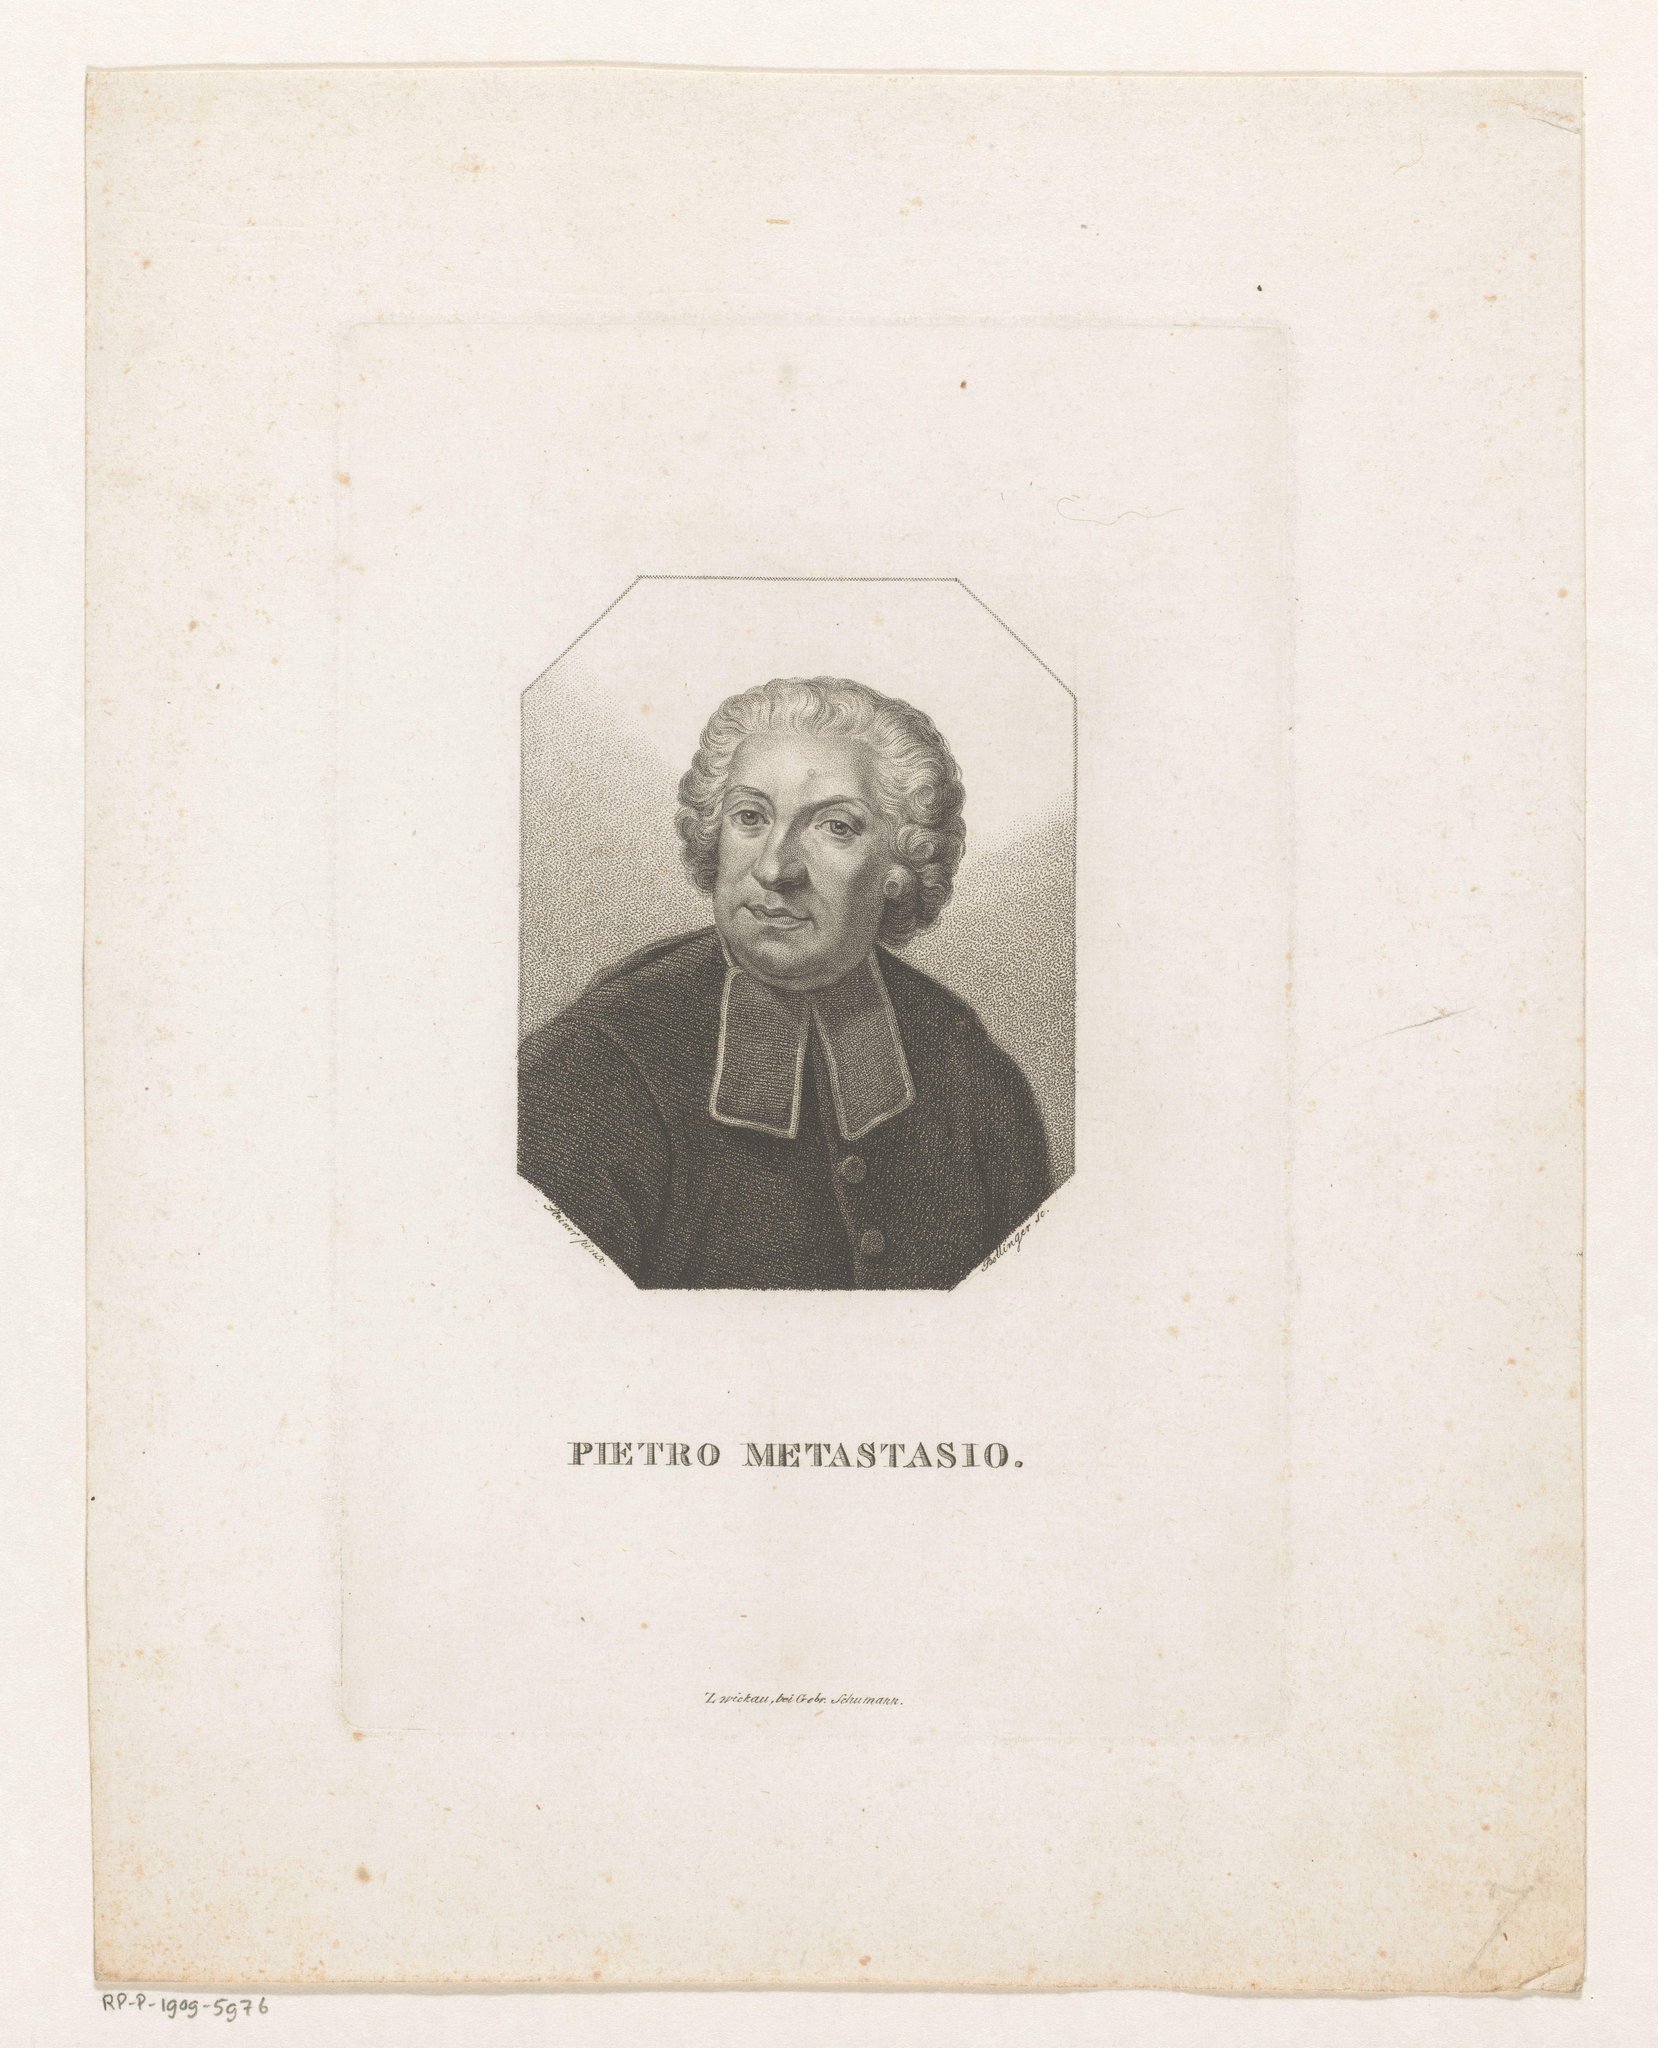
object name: print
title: Portret van Pietro Metastasio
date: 1818-1832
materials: paper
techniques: stippling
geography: berlin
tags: rome, vienna, historical persons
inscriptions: collector's mark: Lugt 2228